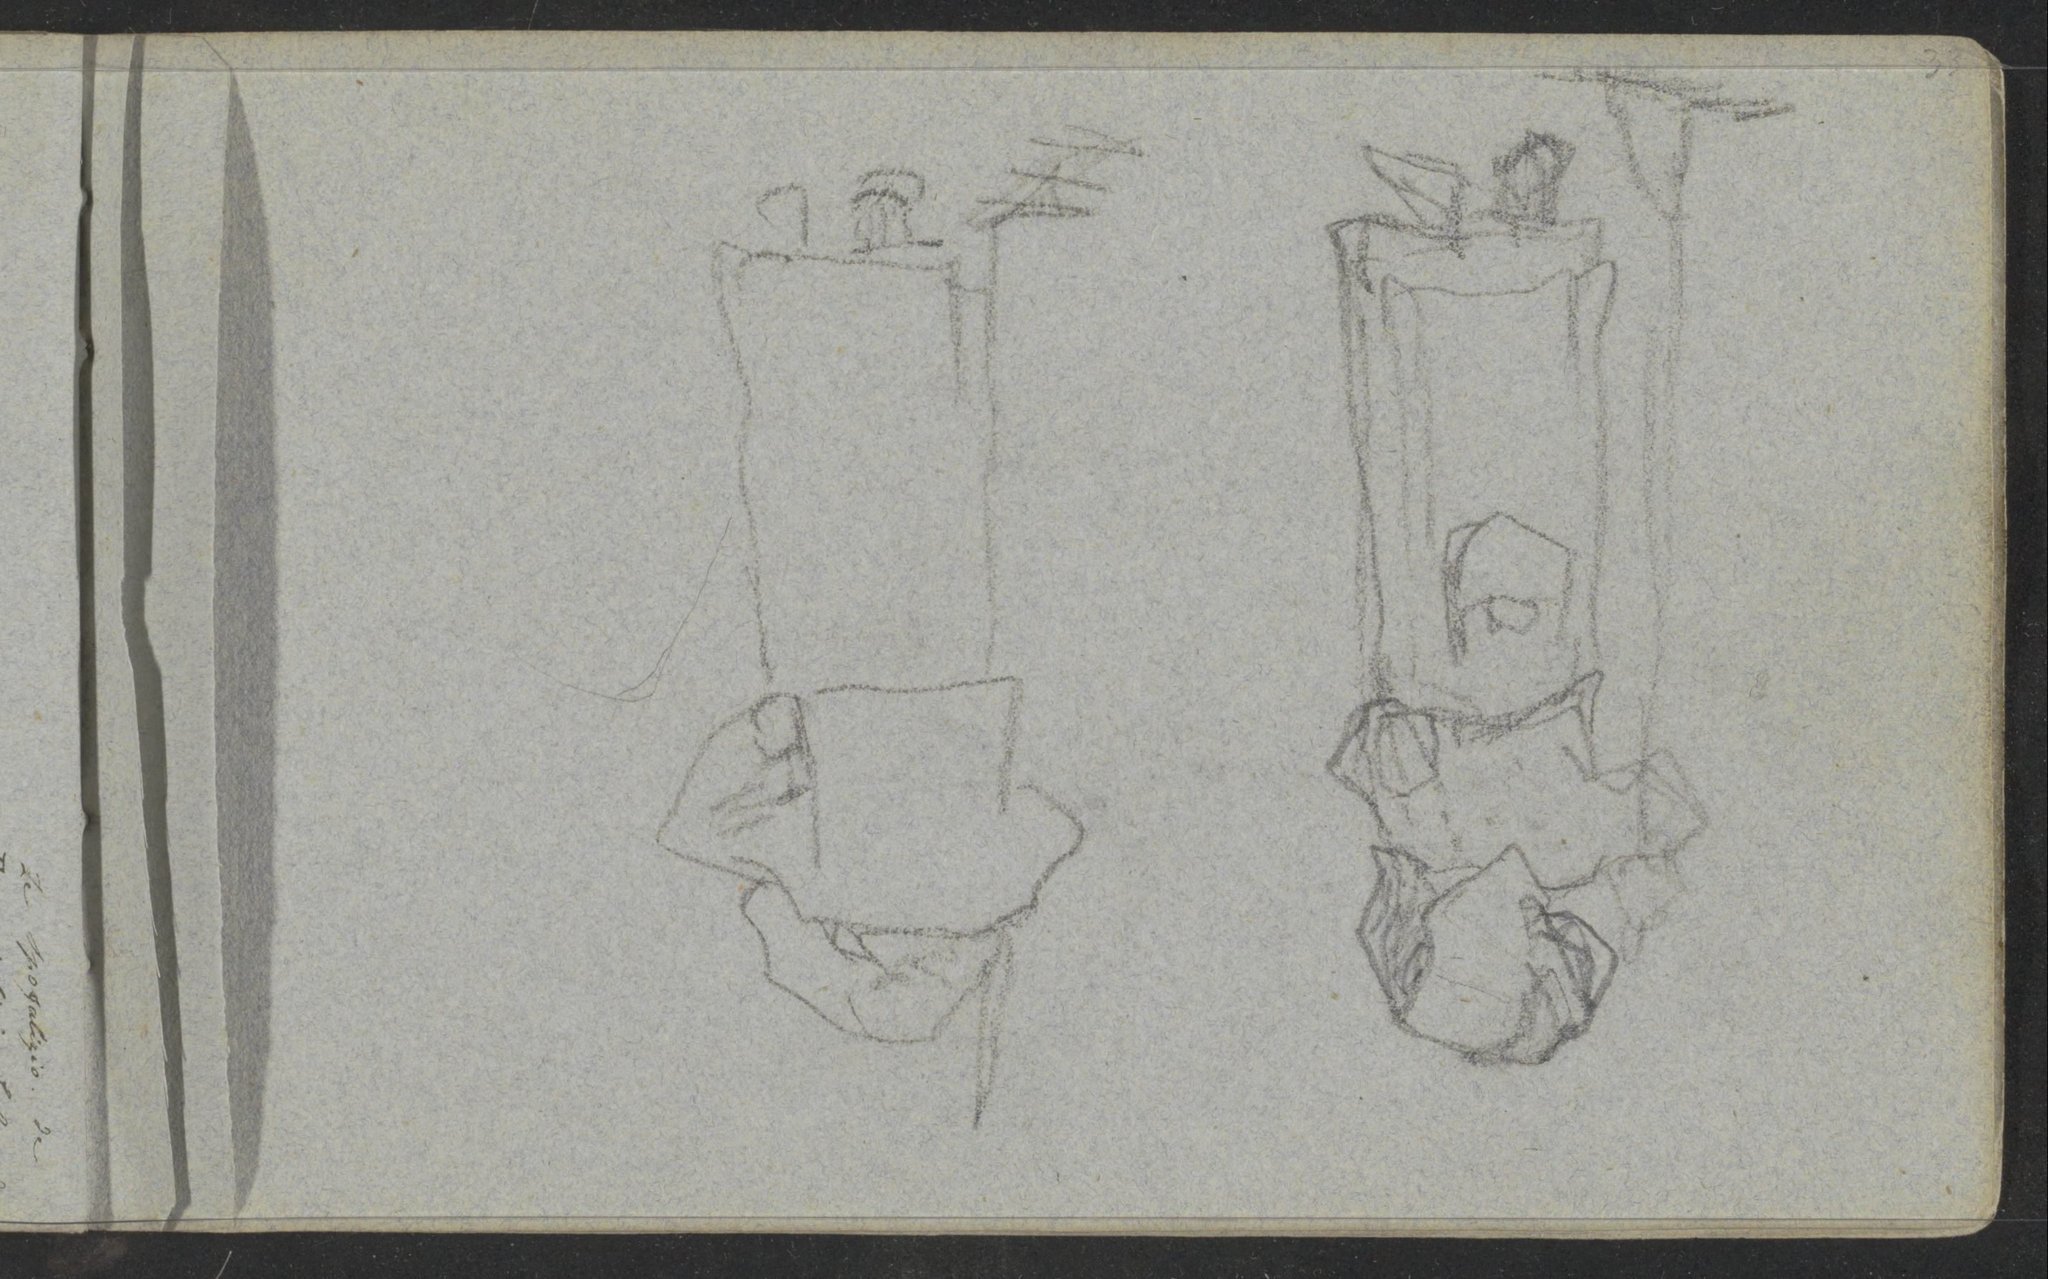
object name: sketchbook leaf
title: Staande figuur met een stok en een mantel met kap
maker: matthijs maris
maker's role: draughtsman, painter, print maker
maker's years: 1839-1917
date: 1849-1917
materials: chalk, paper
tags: standing figure, head-gear: hood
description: Blad 33 recto uit een schetsboek met 35 bladen.